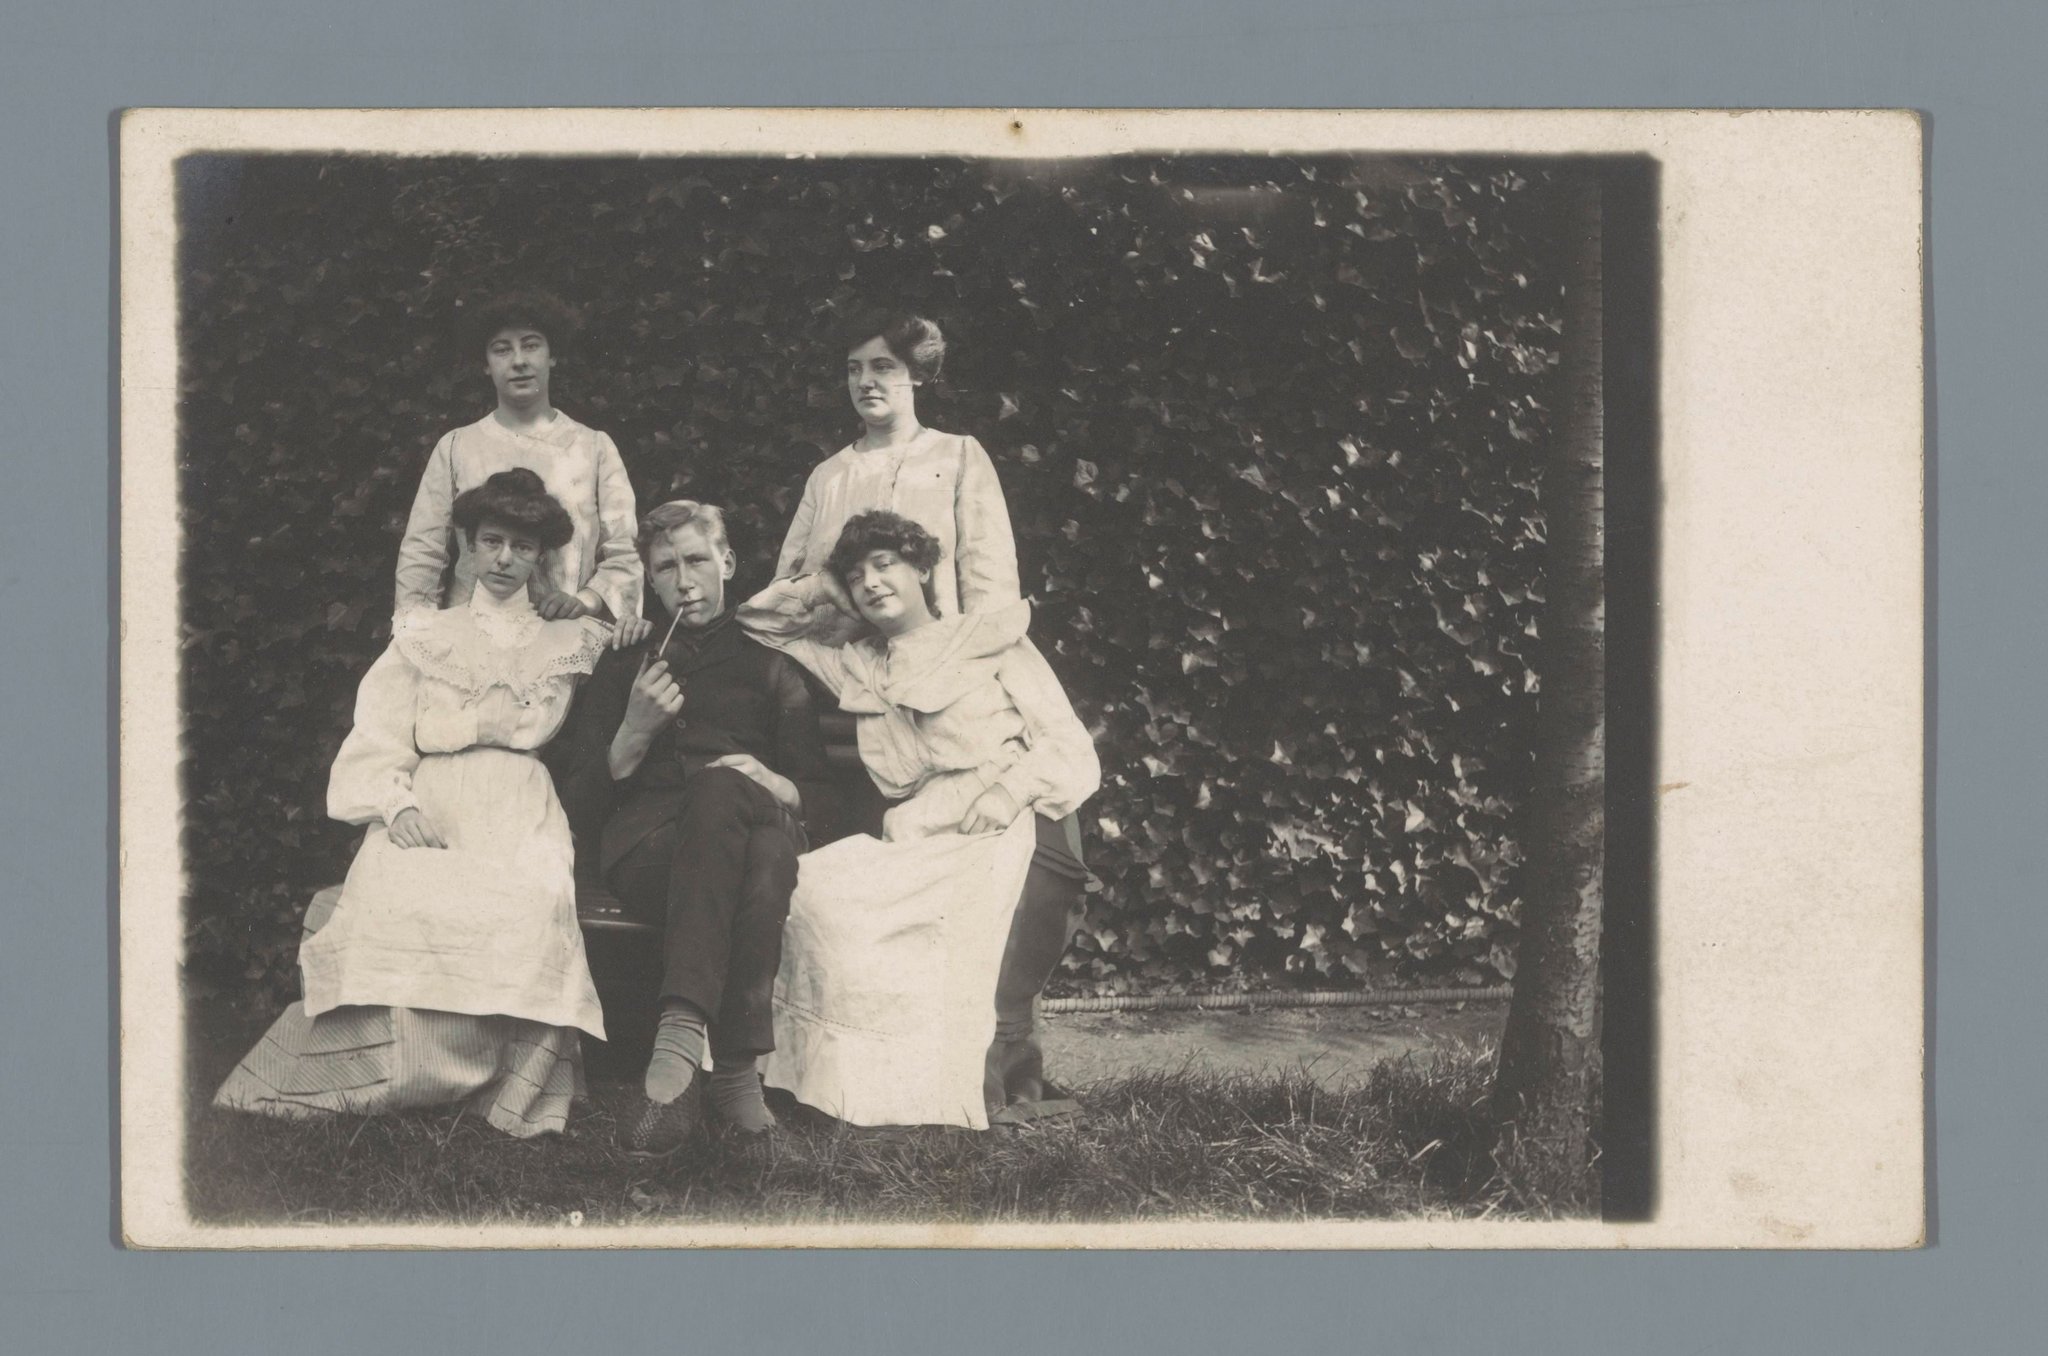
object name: ansichtkaart, prentbriefkaart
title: Groepsportret van een onbekende man en vier onbekende vrouwen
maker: Anonymous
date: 1910-1925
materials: photographic support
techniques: gelatin silver print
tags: adult woman, adult man, anonymous historical persons portrayed in a group, in a group-portrait